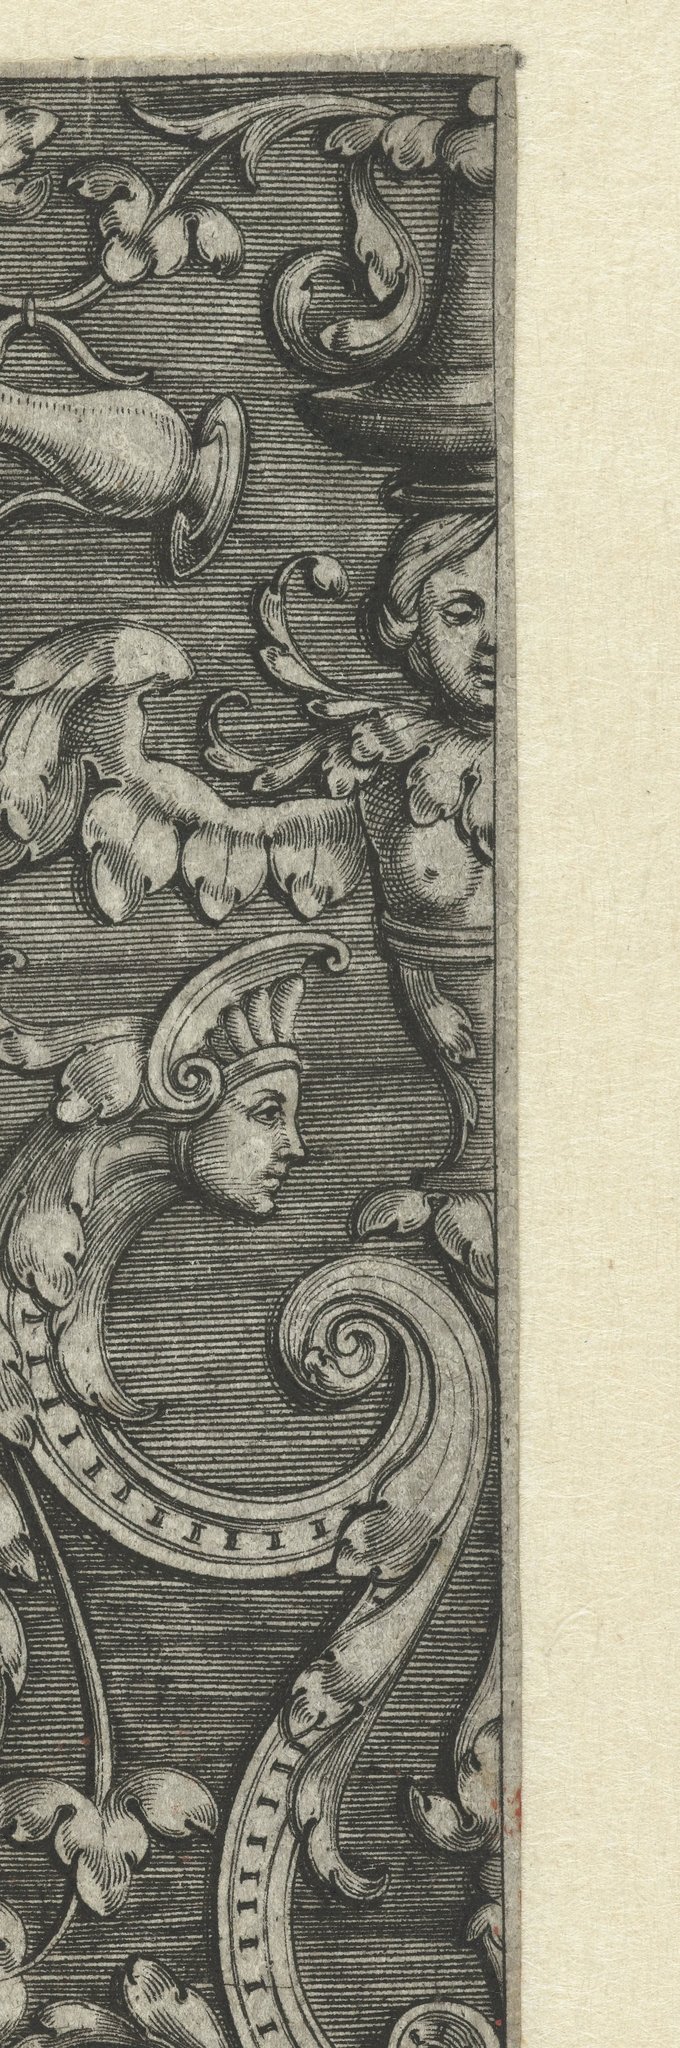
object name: print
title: Ornament met vrouwelijke figuur en kan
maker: monogrammist ig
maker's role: print maker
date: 1522-1530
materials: paper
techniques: engraving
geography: low countries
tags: ornaments ~ art (+ ornament enlivened by hybrid forms), container of ceramics: jar, jug, pot, vase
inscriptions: collector's mark: Lugt 240